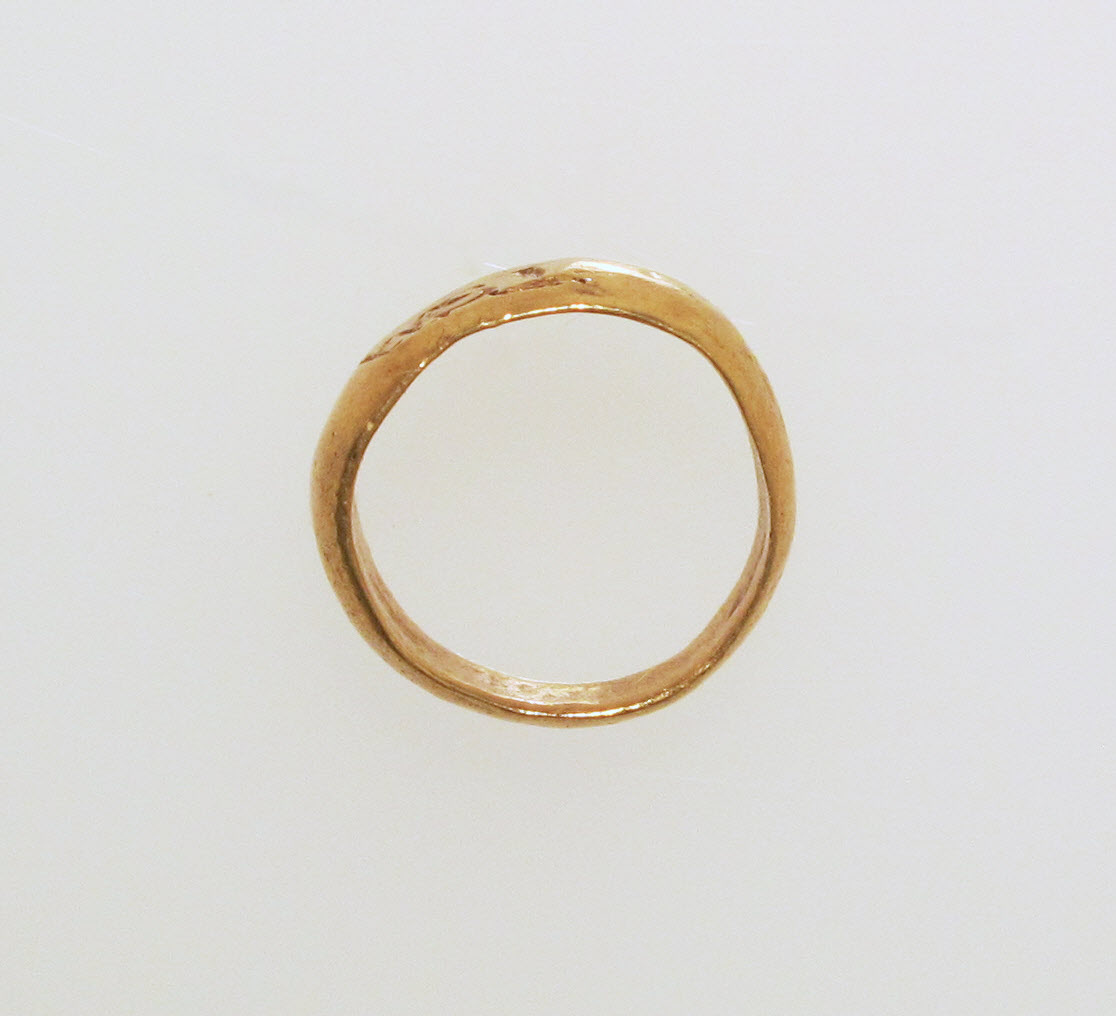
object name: ring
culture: roman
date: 400-201 BCE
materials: gold